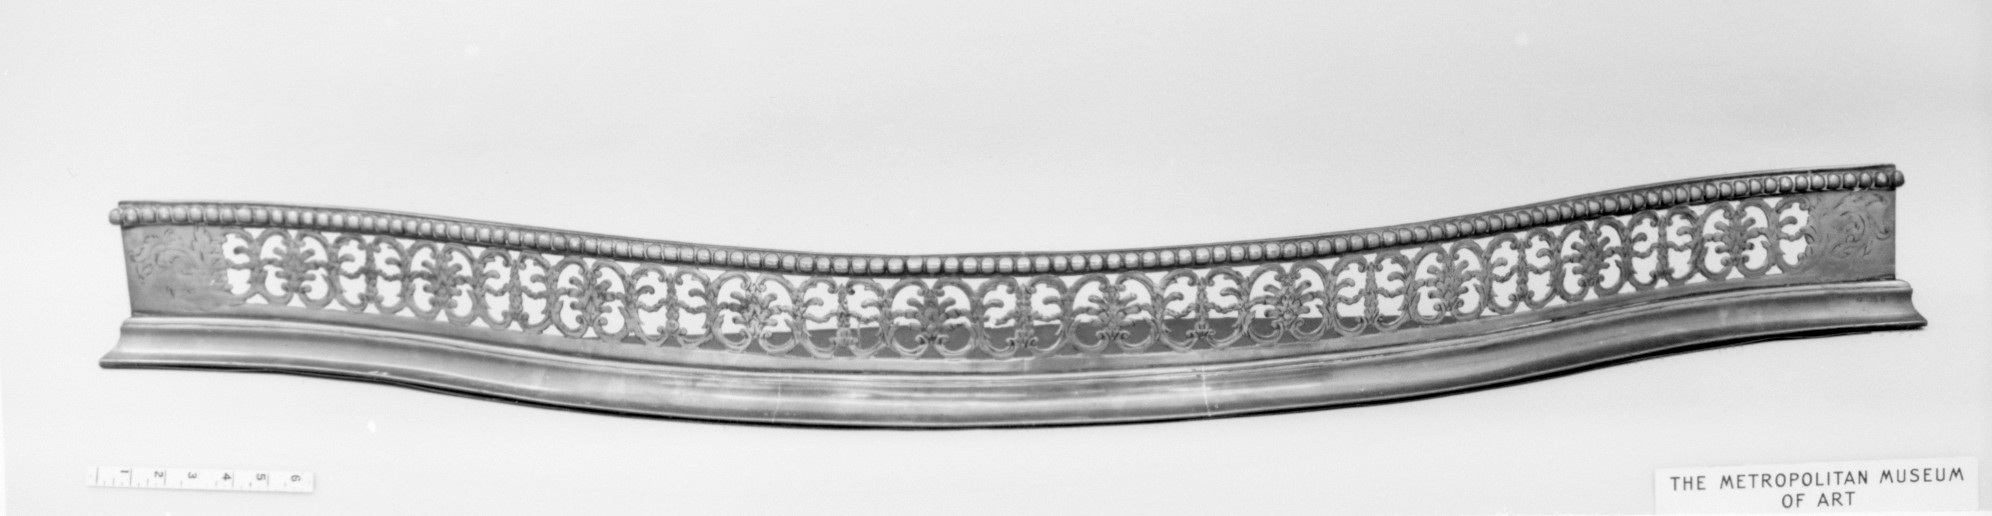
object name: fender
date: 1701-1800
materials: copper